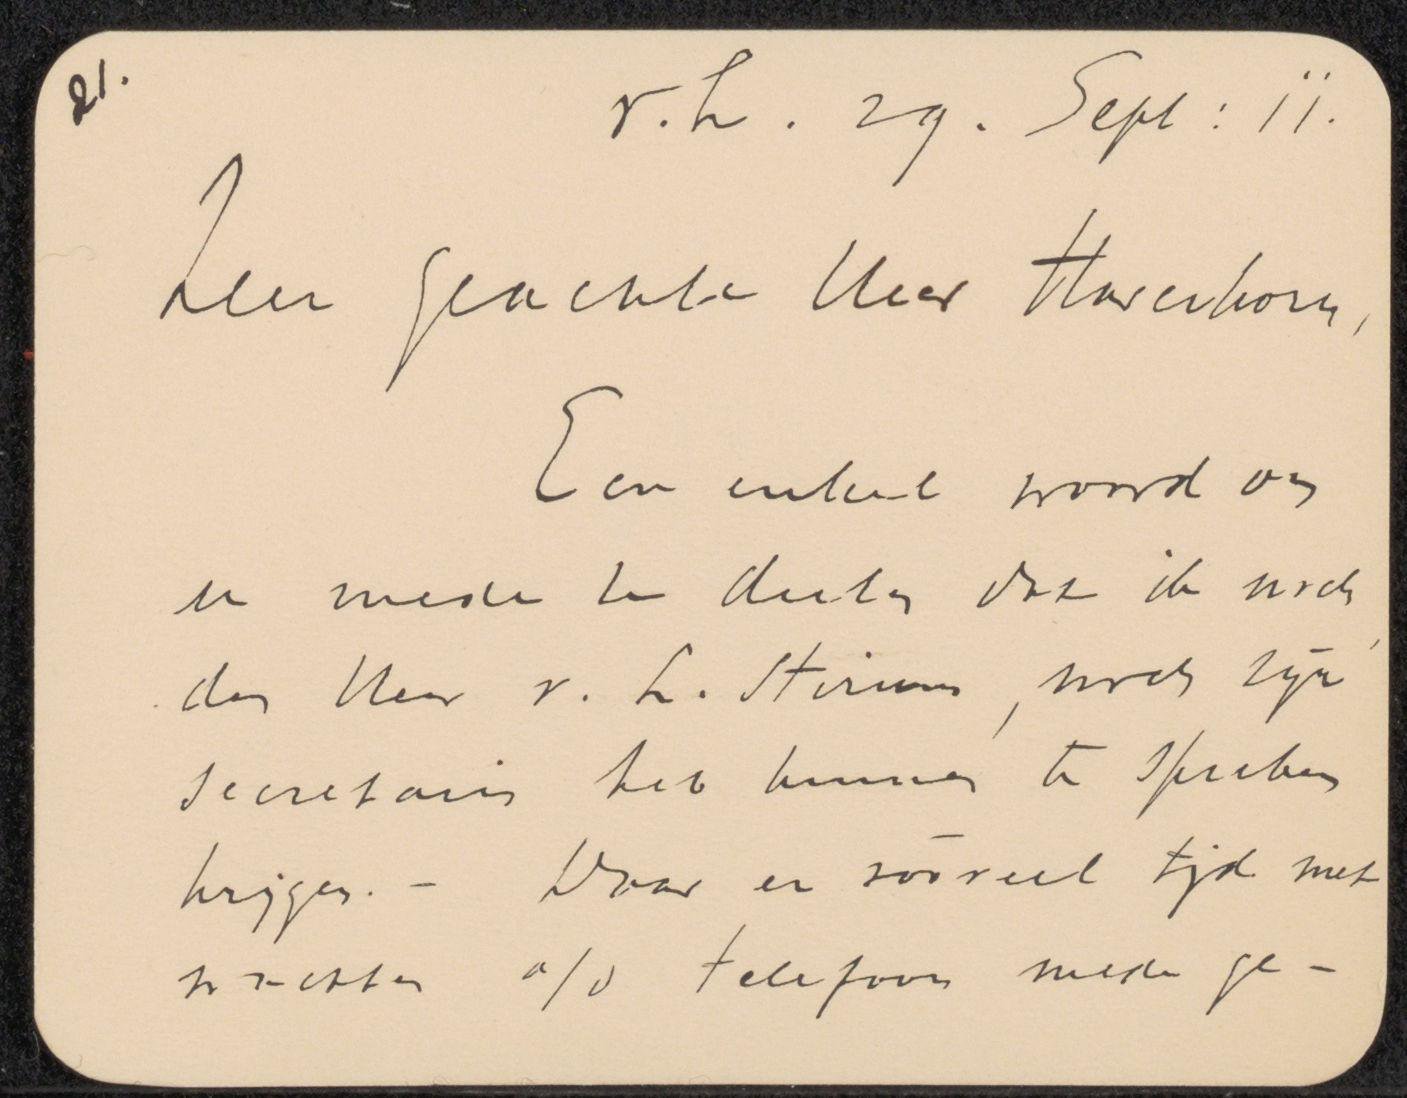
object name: letter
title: Brief aan Pieter Haverkorn van Rijsewijk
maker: w.g. eberson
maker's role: architect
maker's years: 1867-1932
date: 1911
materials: cardboard, ink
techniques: pen, writing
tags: pieter haverkorn van rijsewijk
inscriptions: collector's mark: ‘RPK’